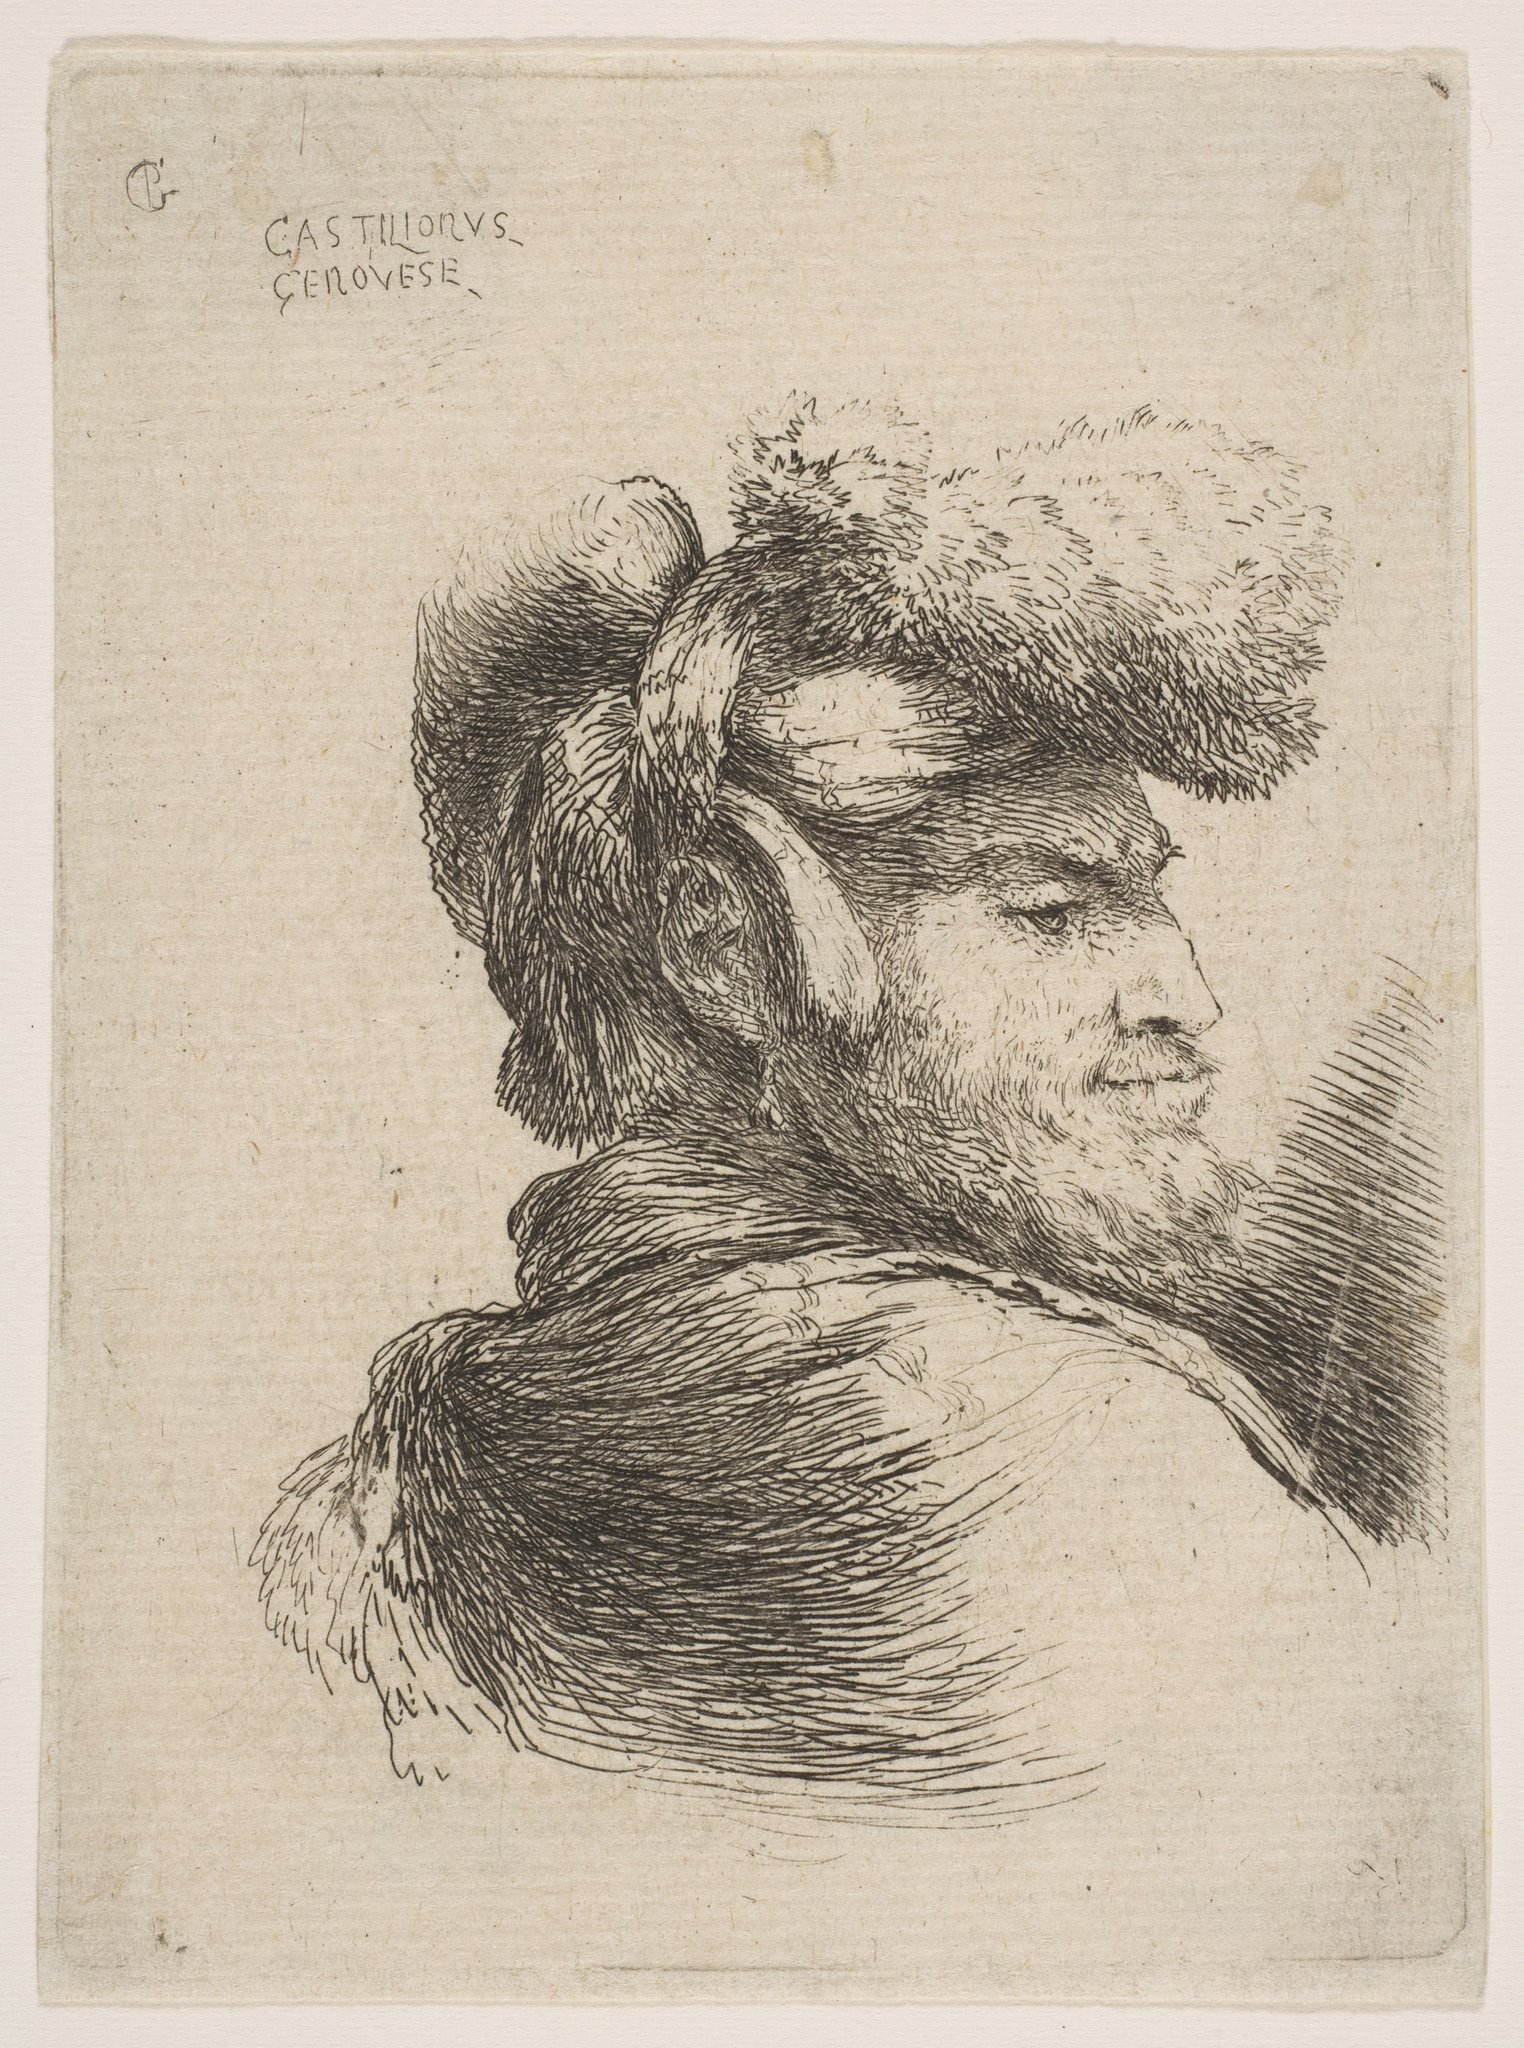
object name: print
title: Man in profile facing right, wearing a fur hat, from "Small Heads in Oriental Headdress"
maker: giovanni benedetto castiglione (il grechetto)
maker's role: artist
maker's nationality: italian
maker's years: 1609-1664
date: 1645-1650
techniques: etching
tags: hats,men,profiles